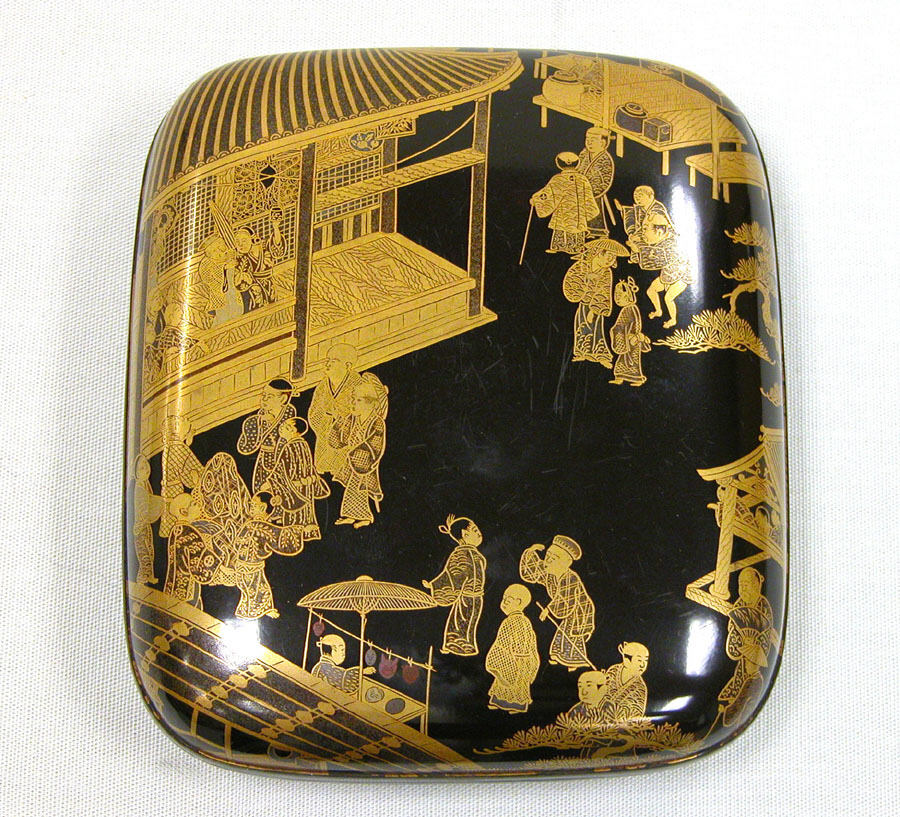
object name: incense box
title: Small Box (Kobako) with Kyōgen Theater Scene at Mibu Temple in Kyoto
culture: japanese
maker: kōami shinzaburō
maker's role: artist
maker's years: 1750-1799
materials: gold, silver, wood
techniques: lacquer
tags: human figures,houses